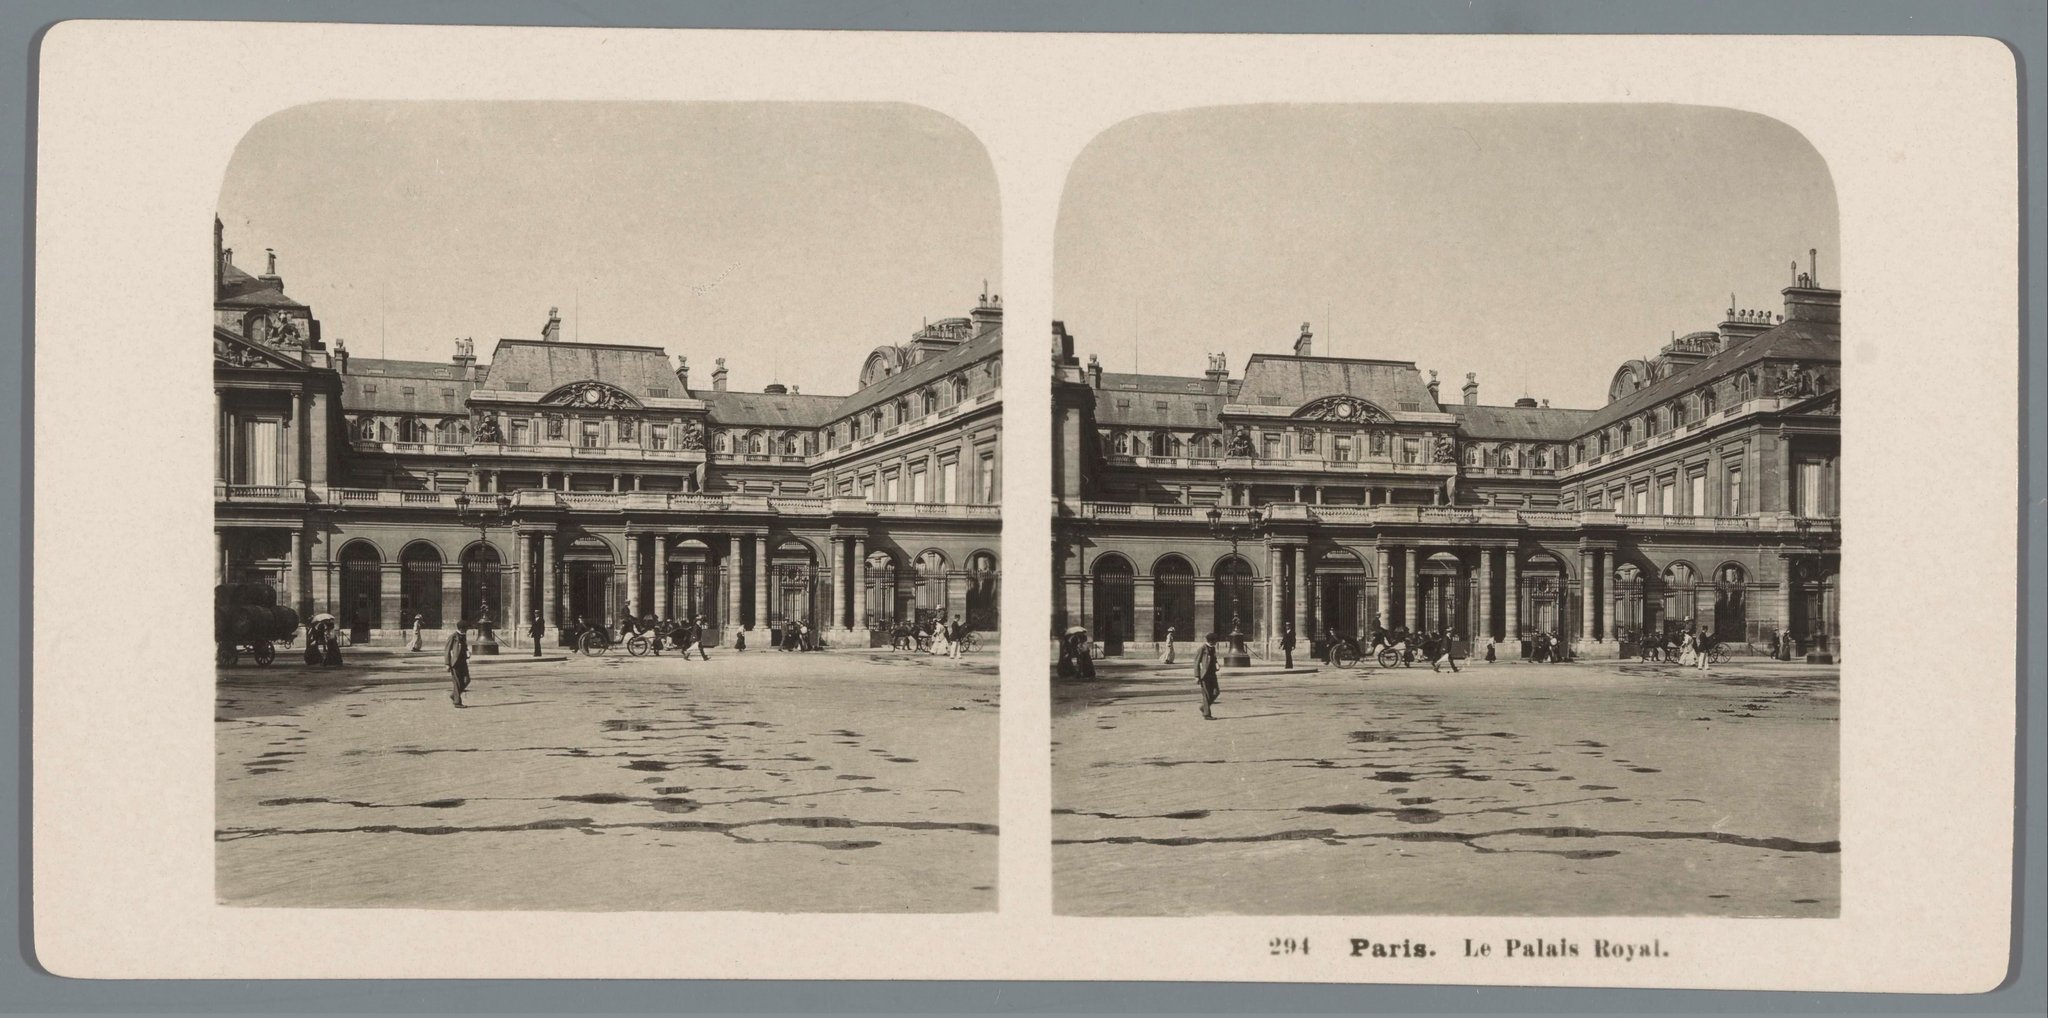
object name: stereograph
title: Paris. Le Palais Royal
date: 1904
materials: cardboard, photographic support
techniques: gelatin silver print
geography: paris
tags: palace, façade (of house or building)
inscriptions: inscription: ‘Neue Photographische Gesellschaft A.-G. Steglitz-Berlin 1904.’, number: ‘294’